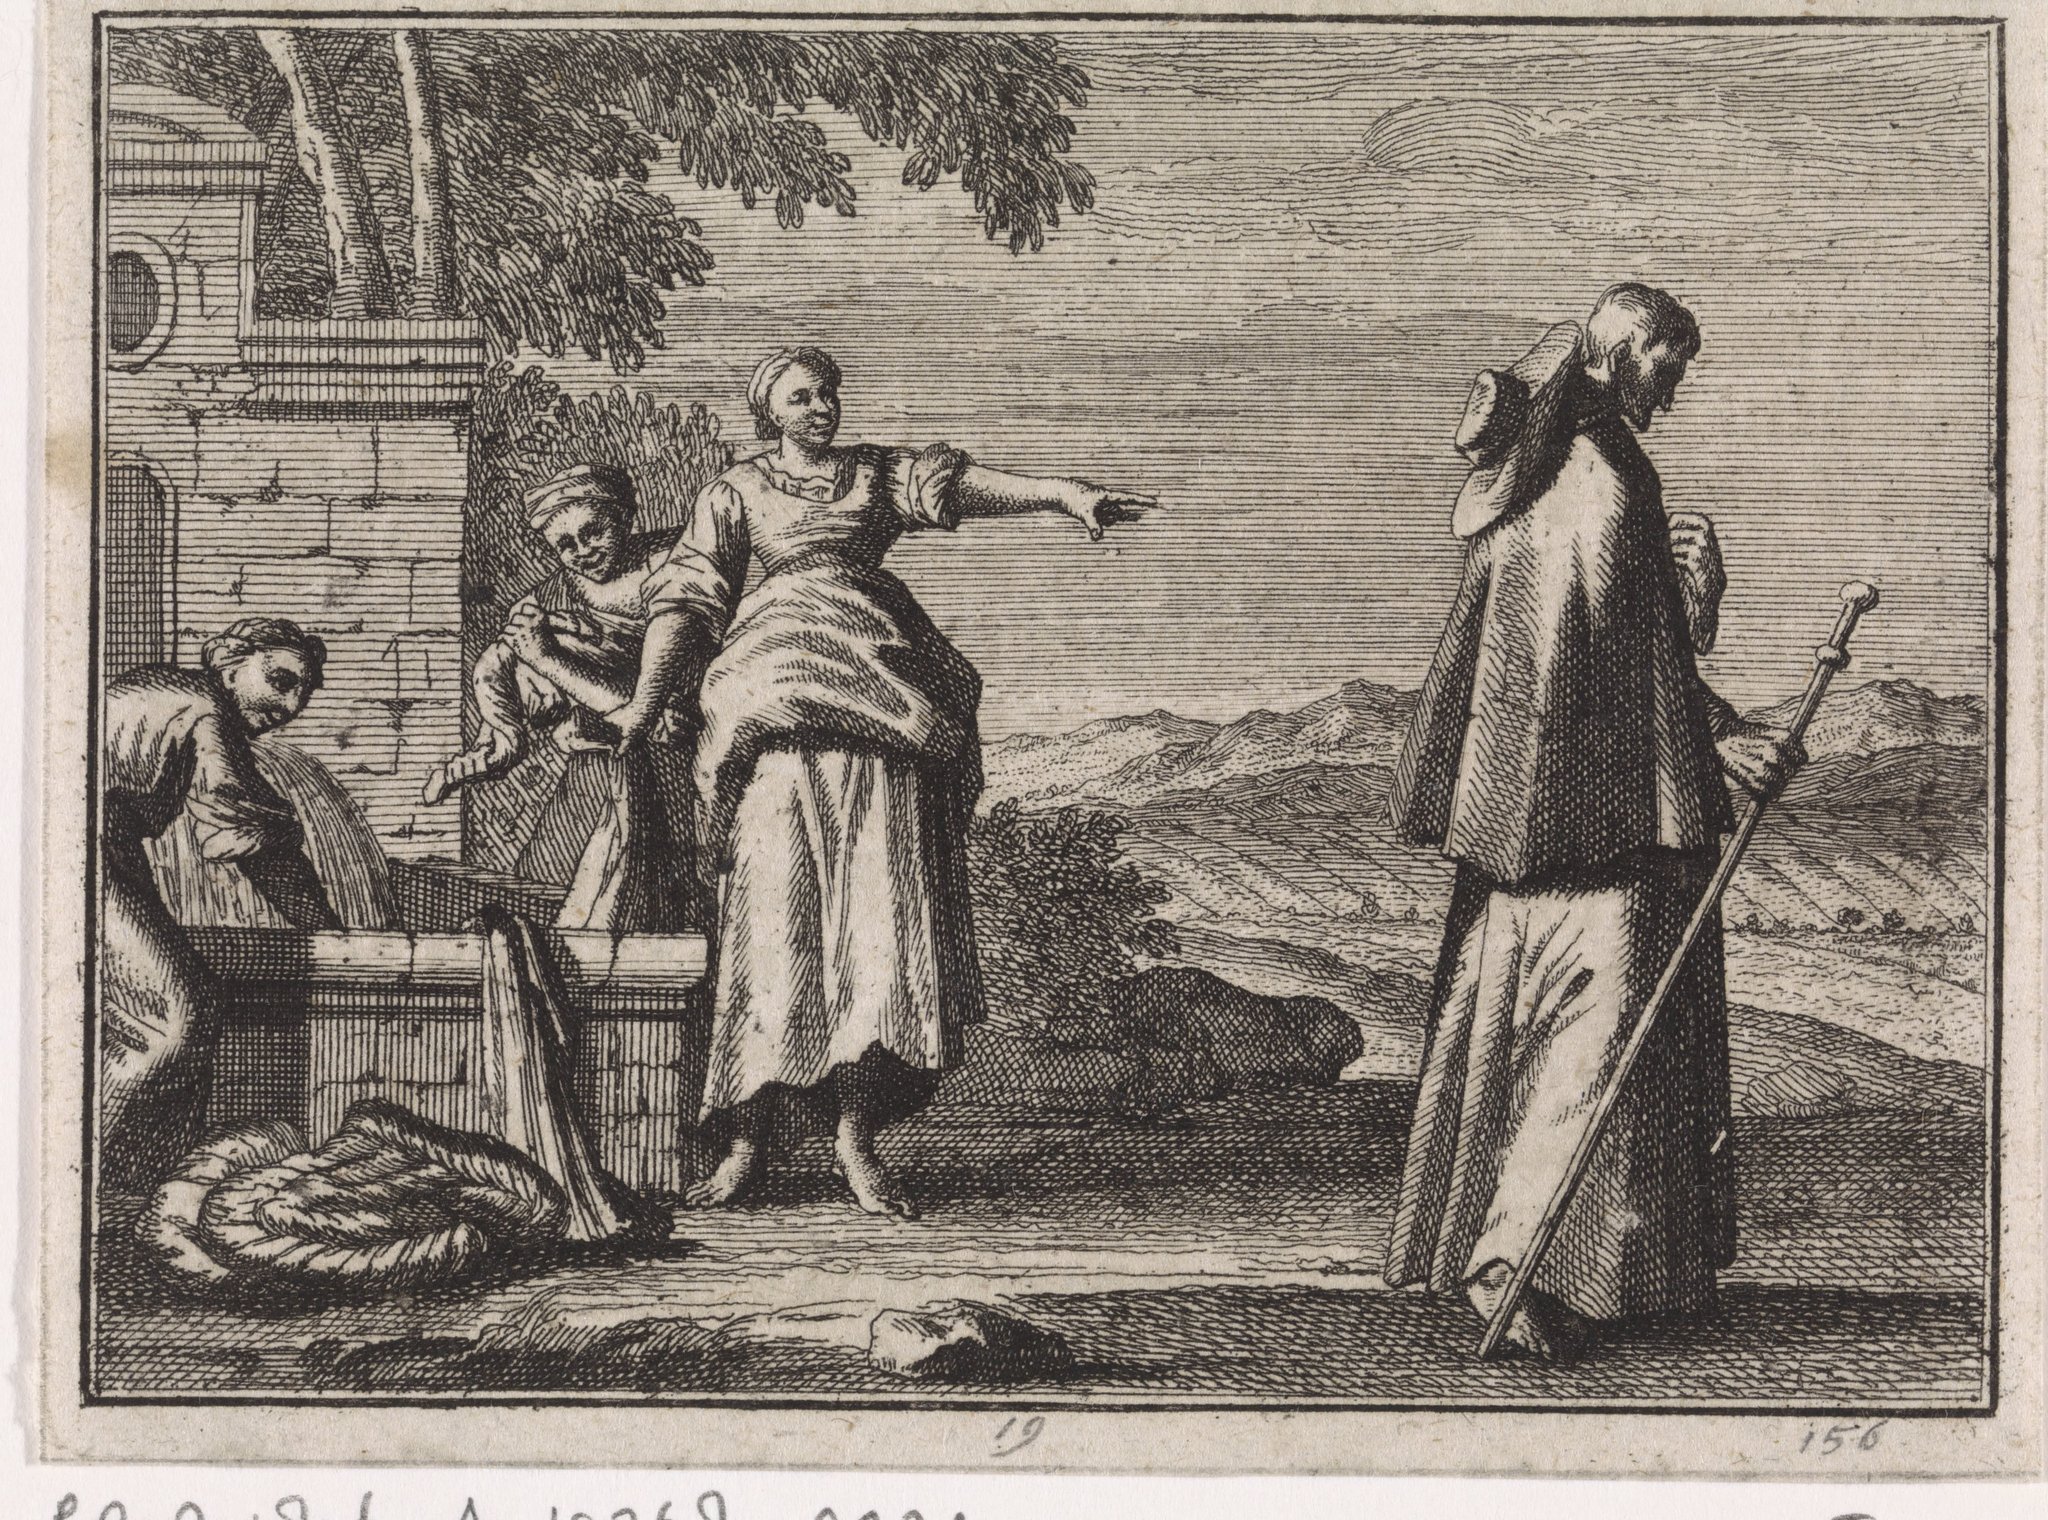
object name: print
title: Lach, Echo, Ach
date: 1704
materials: paper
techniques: etching, letterpress printing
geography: nuremberg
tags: mocking, insulting; teasing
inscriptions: collector's mark: Lugt 2228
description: Illustratie uit: Abraham a Sancta Clara. Heilsames Gemisch Gemasch, das ist: Allerley seltsame und verwunderliche Geschichten (...). Neurenberg: Christoph Weigel, 1704, p. 156.